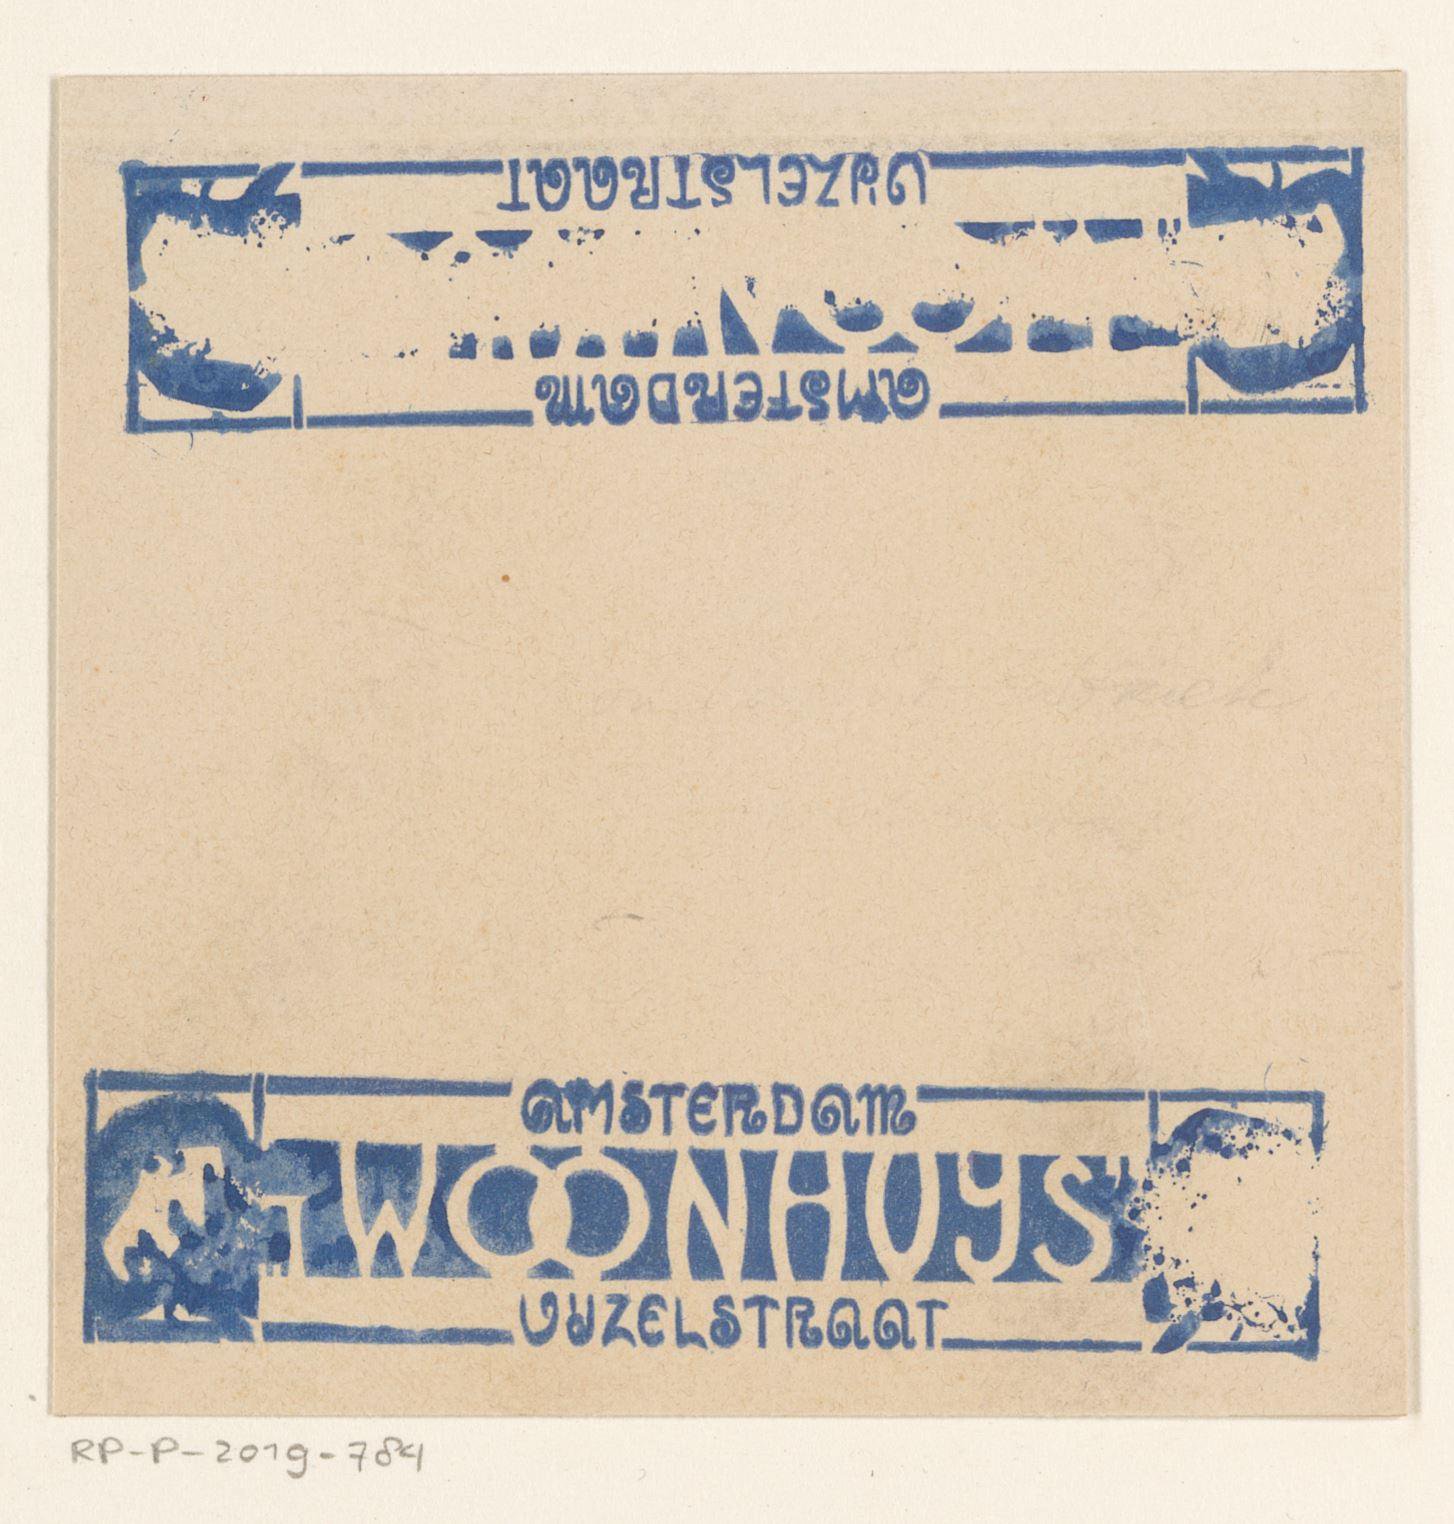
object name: print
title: Logo van meubelfabriek 't Woonhuys te Amsterdam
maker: Anonymous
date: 1907-1929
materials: ink, paper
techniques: printing